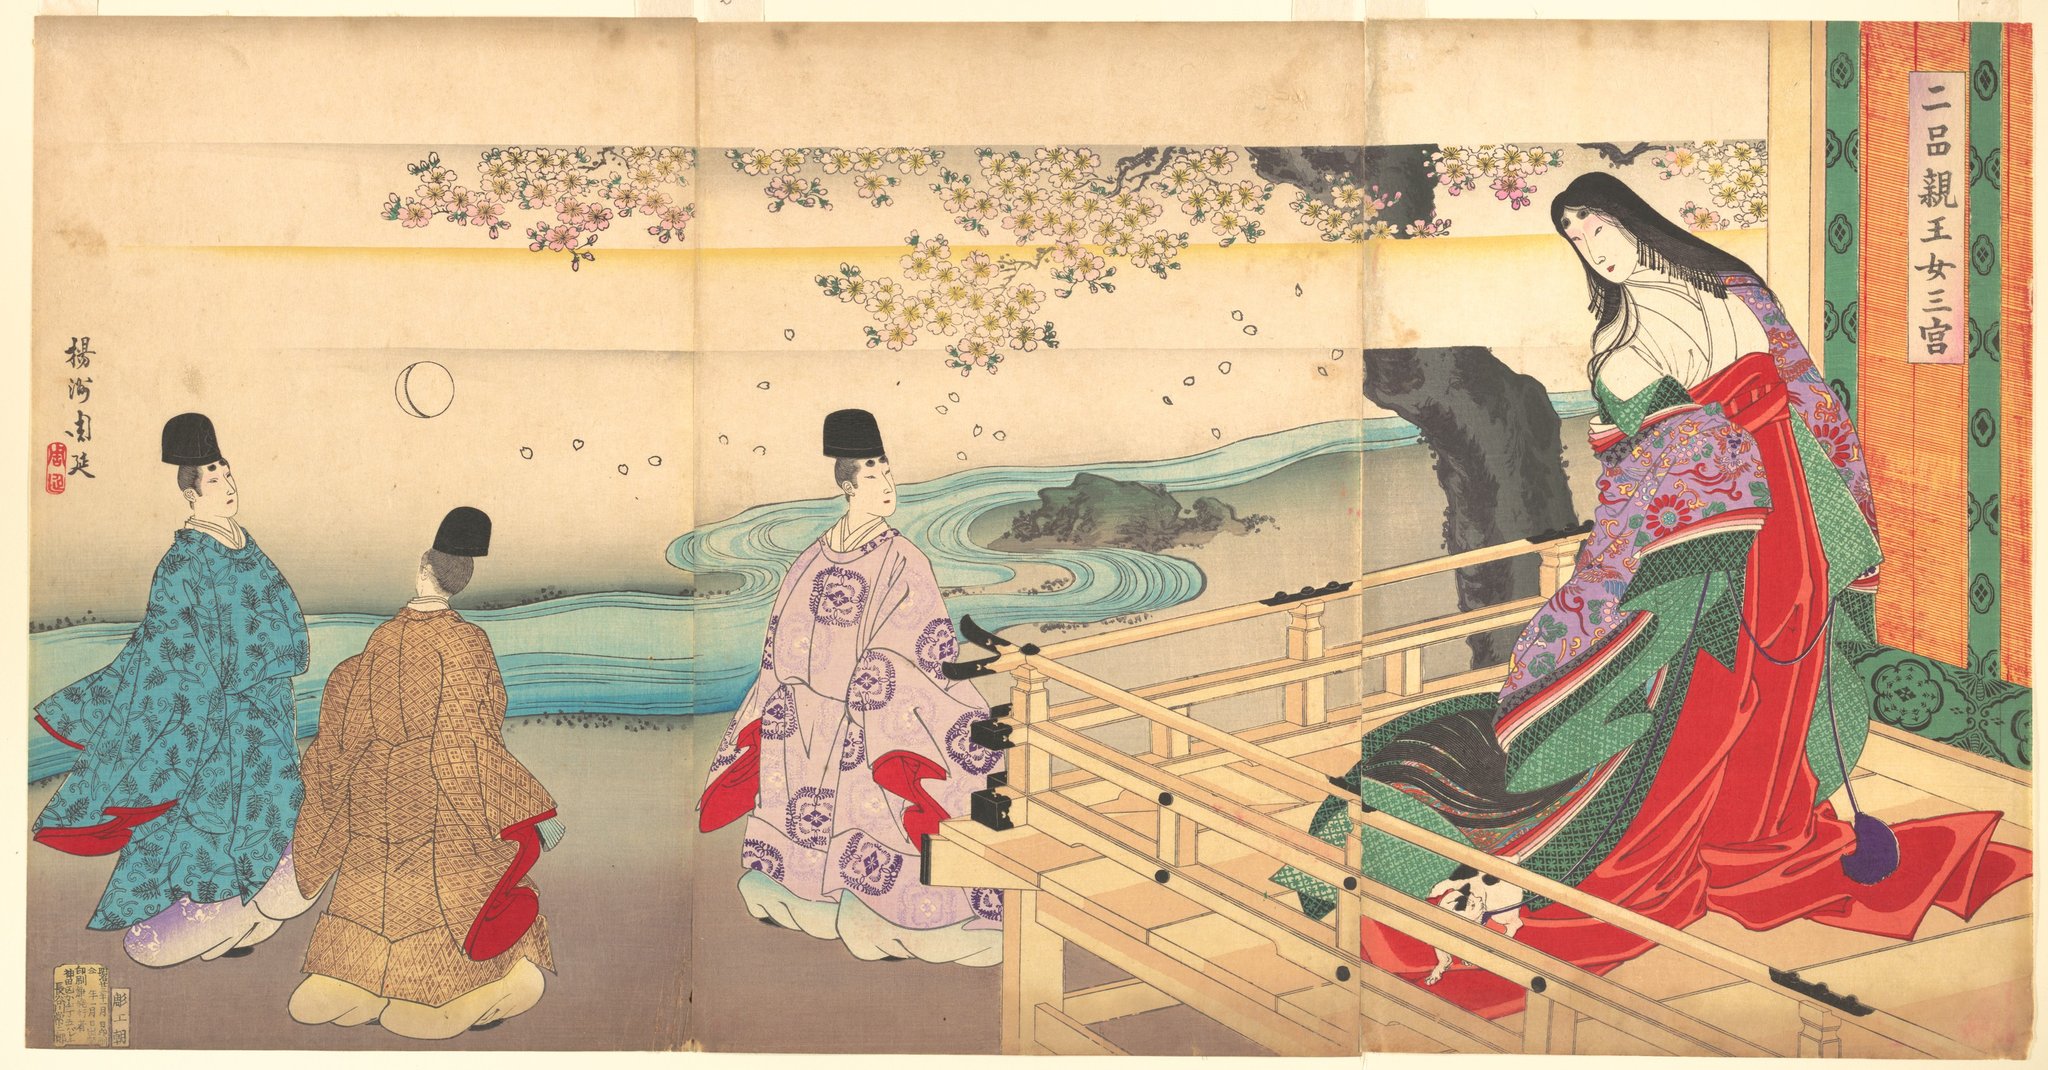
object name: print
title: The Third Princess and Kashiwagi, from Chapter 34, “New Herbs I (Wakana I)” (Nihon shinnō onna sannomiya)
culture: japanese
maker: yōshū (hashimoto) chikanobu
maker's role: artist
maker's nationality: japanese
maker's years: 1838-1912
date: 1890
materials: ink, paper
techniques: woodblock print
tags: princesses,men,trees